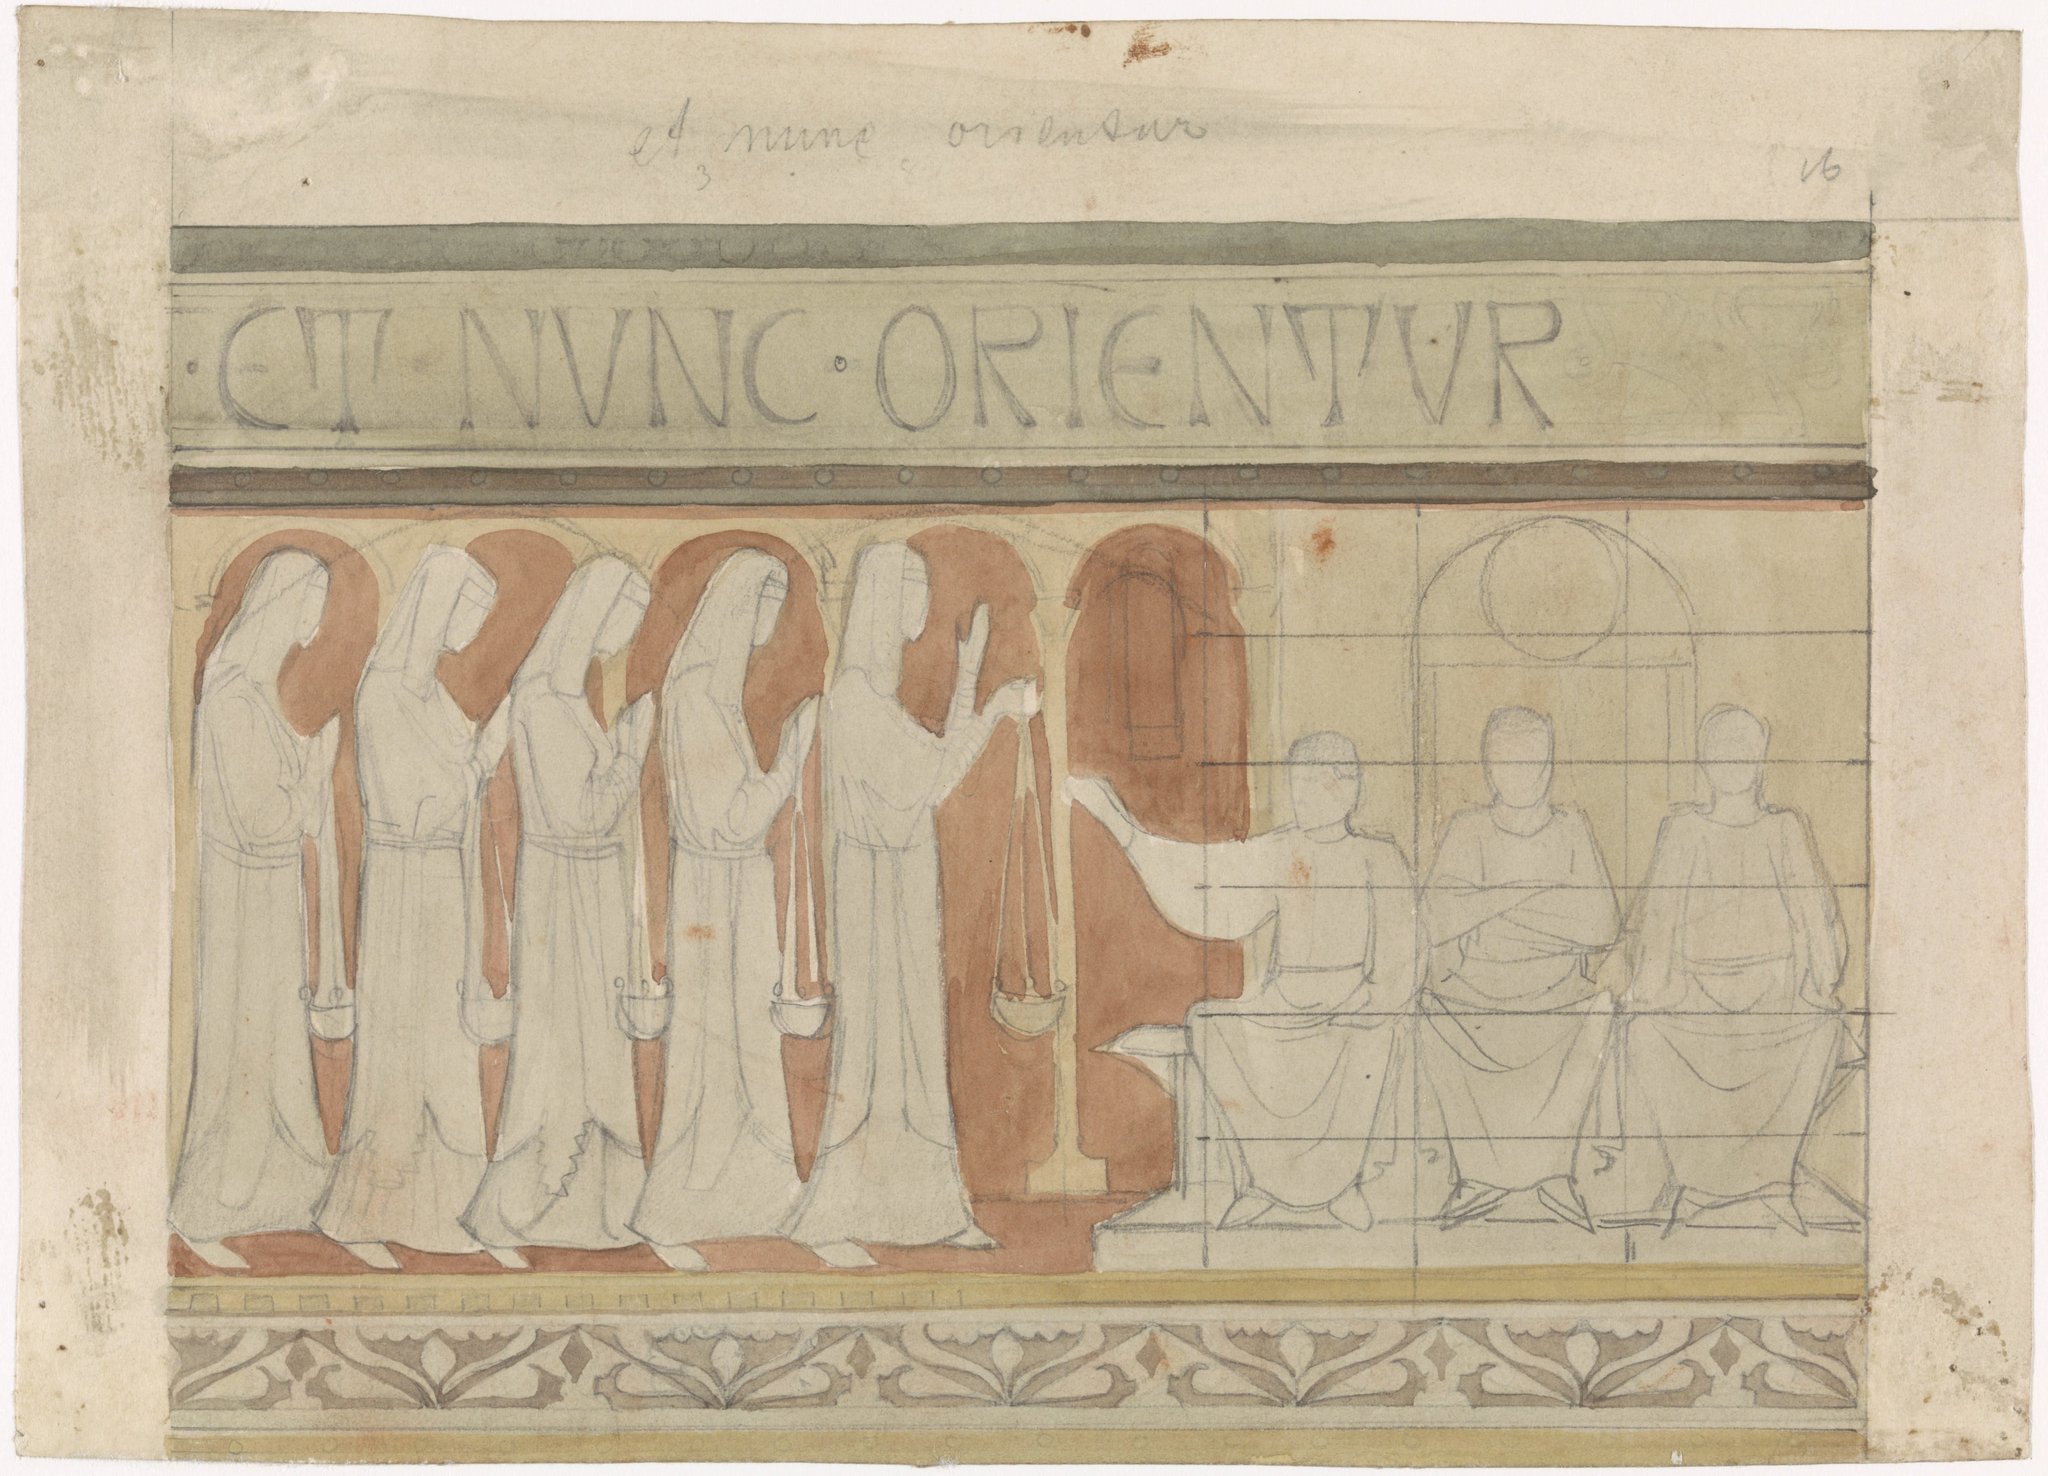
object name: watercolor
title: De vijf dwaze maagden vragen om olie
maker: antoon derkinderen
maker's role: draughtsman, painter, print maker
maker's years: 1859-1925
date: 1869-1925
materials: paper, pencil, watercolor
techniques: brush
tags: the wise virgins are let into the house with the bridegroom (christ); the foolish virgins are shut out (+ variant)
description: De tekening betreft een ontwerp voor een wandschildering.